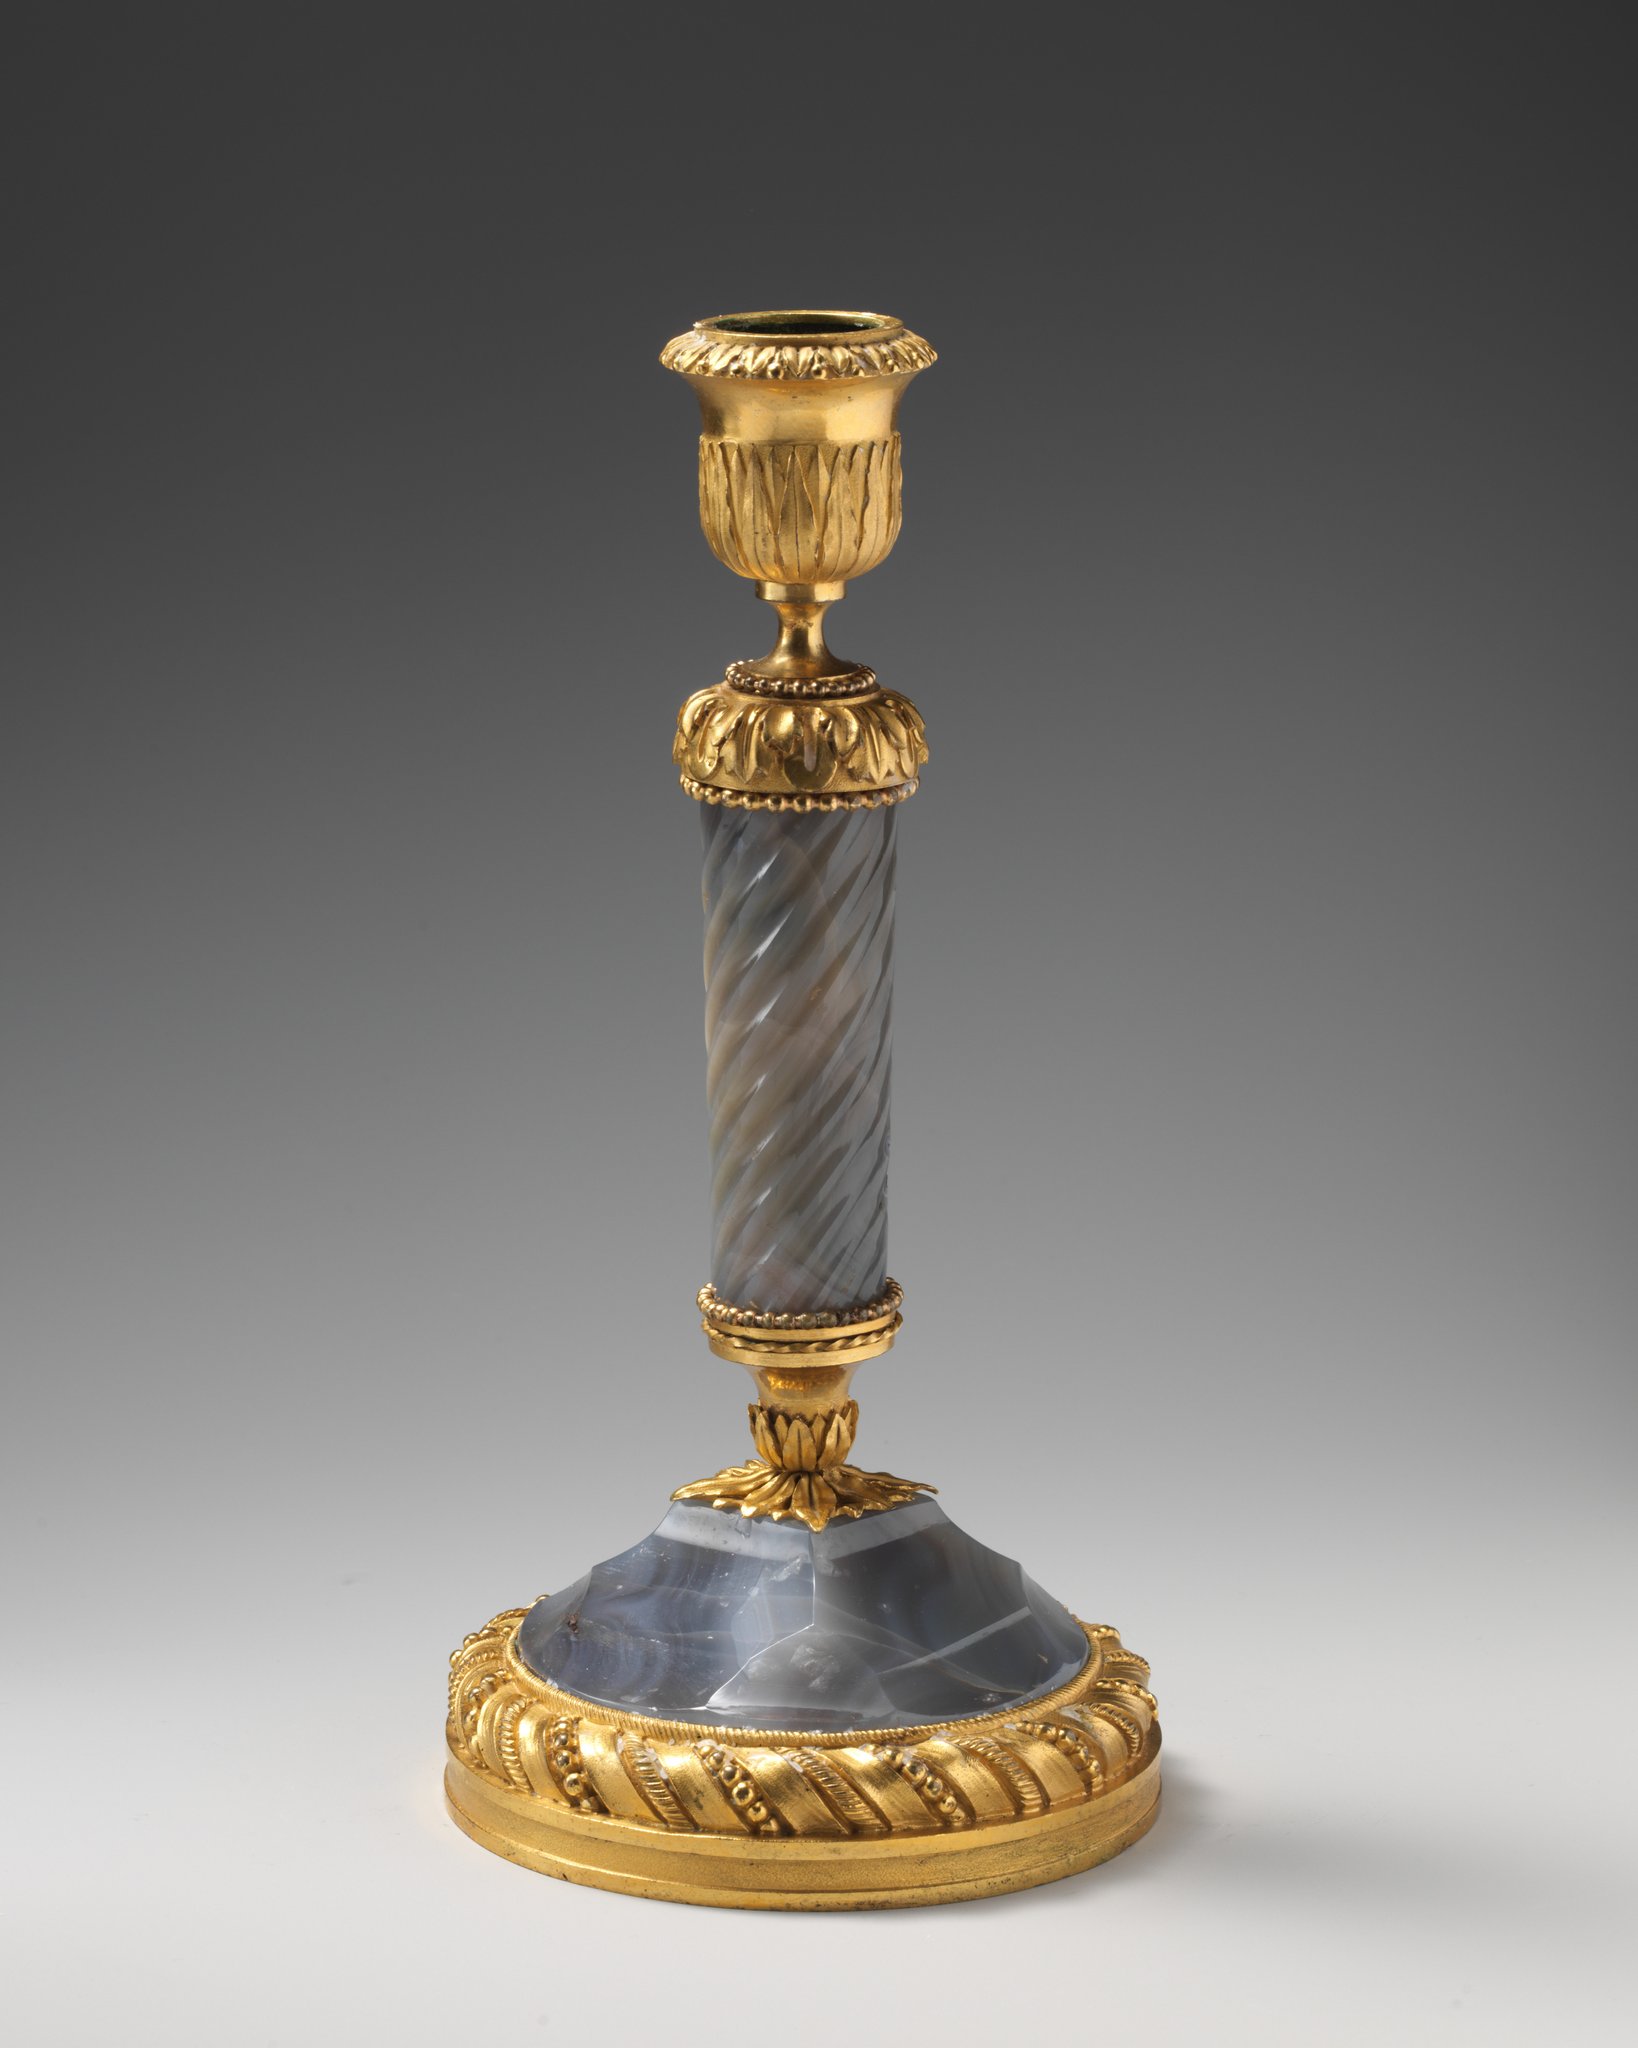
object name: candlestick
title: Candlestick (one of a pair)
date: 1775-1790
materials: stone, gilt bronze